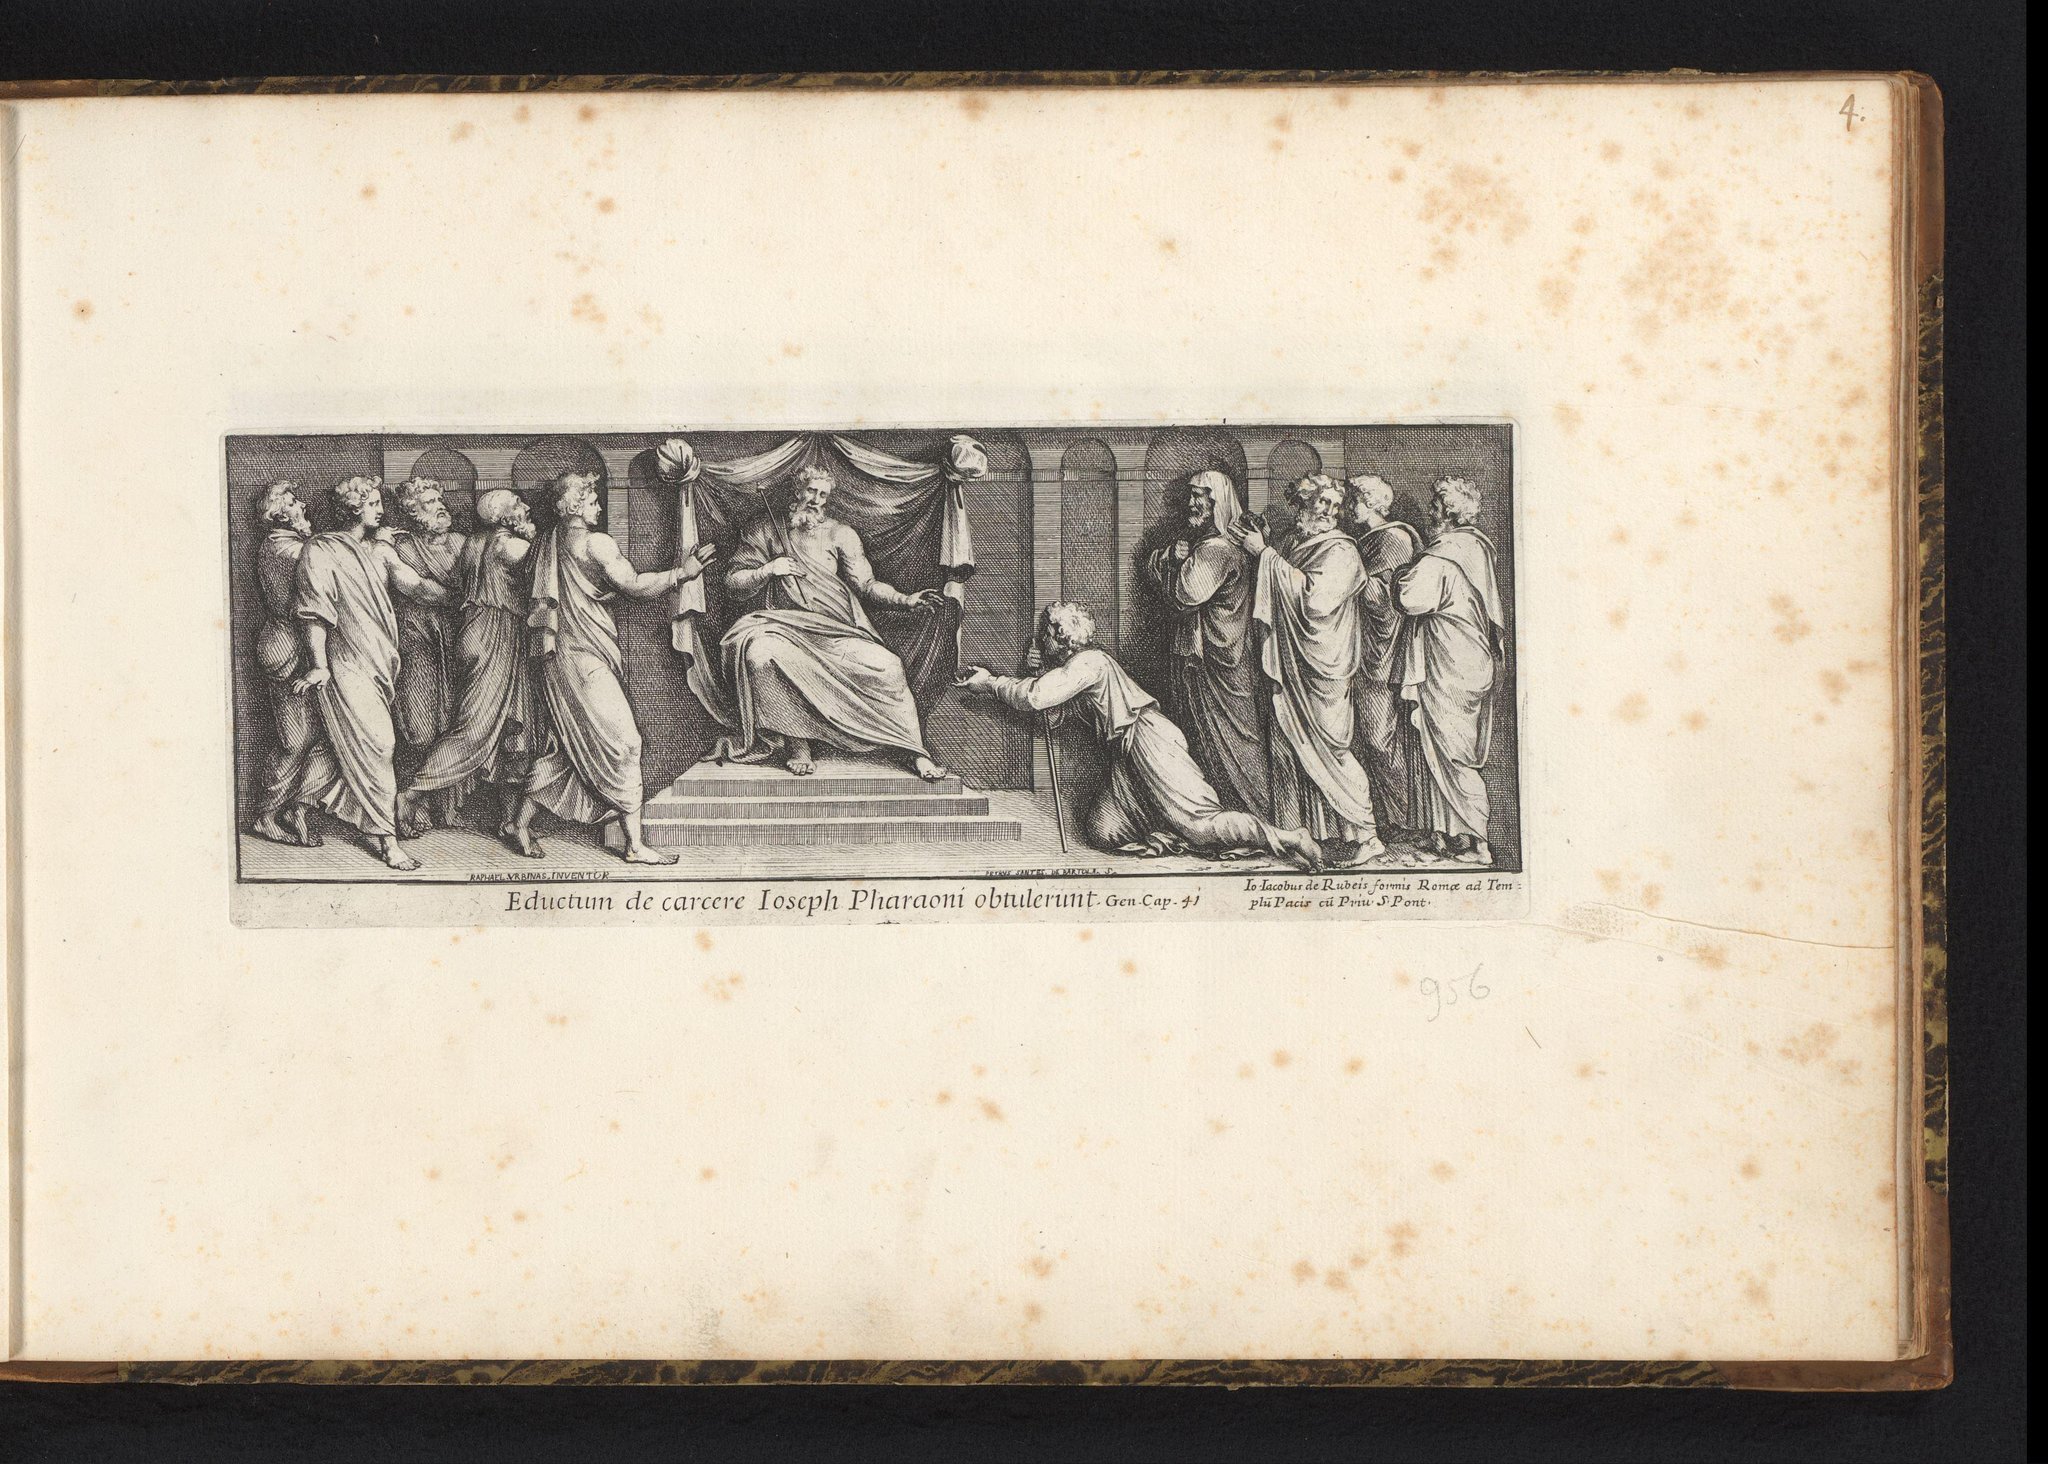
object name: album leaf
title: Eductuum de carcere Ioseph Pharaoni obtulerunt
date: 1645-1700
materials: paper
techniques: engraving, etching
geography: italy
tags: story of joseph (part i)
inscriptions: number: ‘4’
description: Prent uit een reeks van 14 prenten (+ titelprent) naar schilderingen door Rafaël in de Stanze di Raffaello in het Apostolisch Paleis in het Vaticaan en naar ontwerpen voor wandtapijten voor de Sixtijnse Kapel door Rafaël. Naar een schildering door Rafaël in de Stanza di Eliodoro.